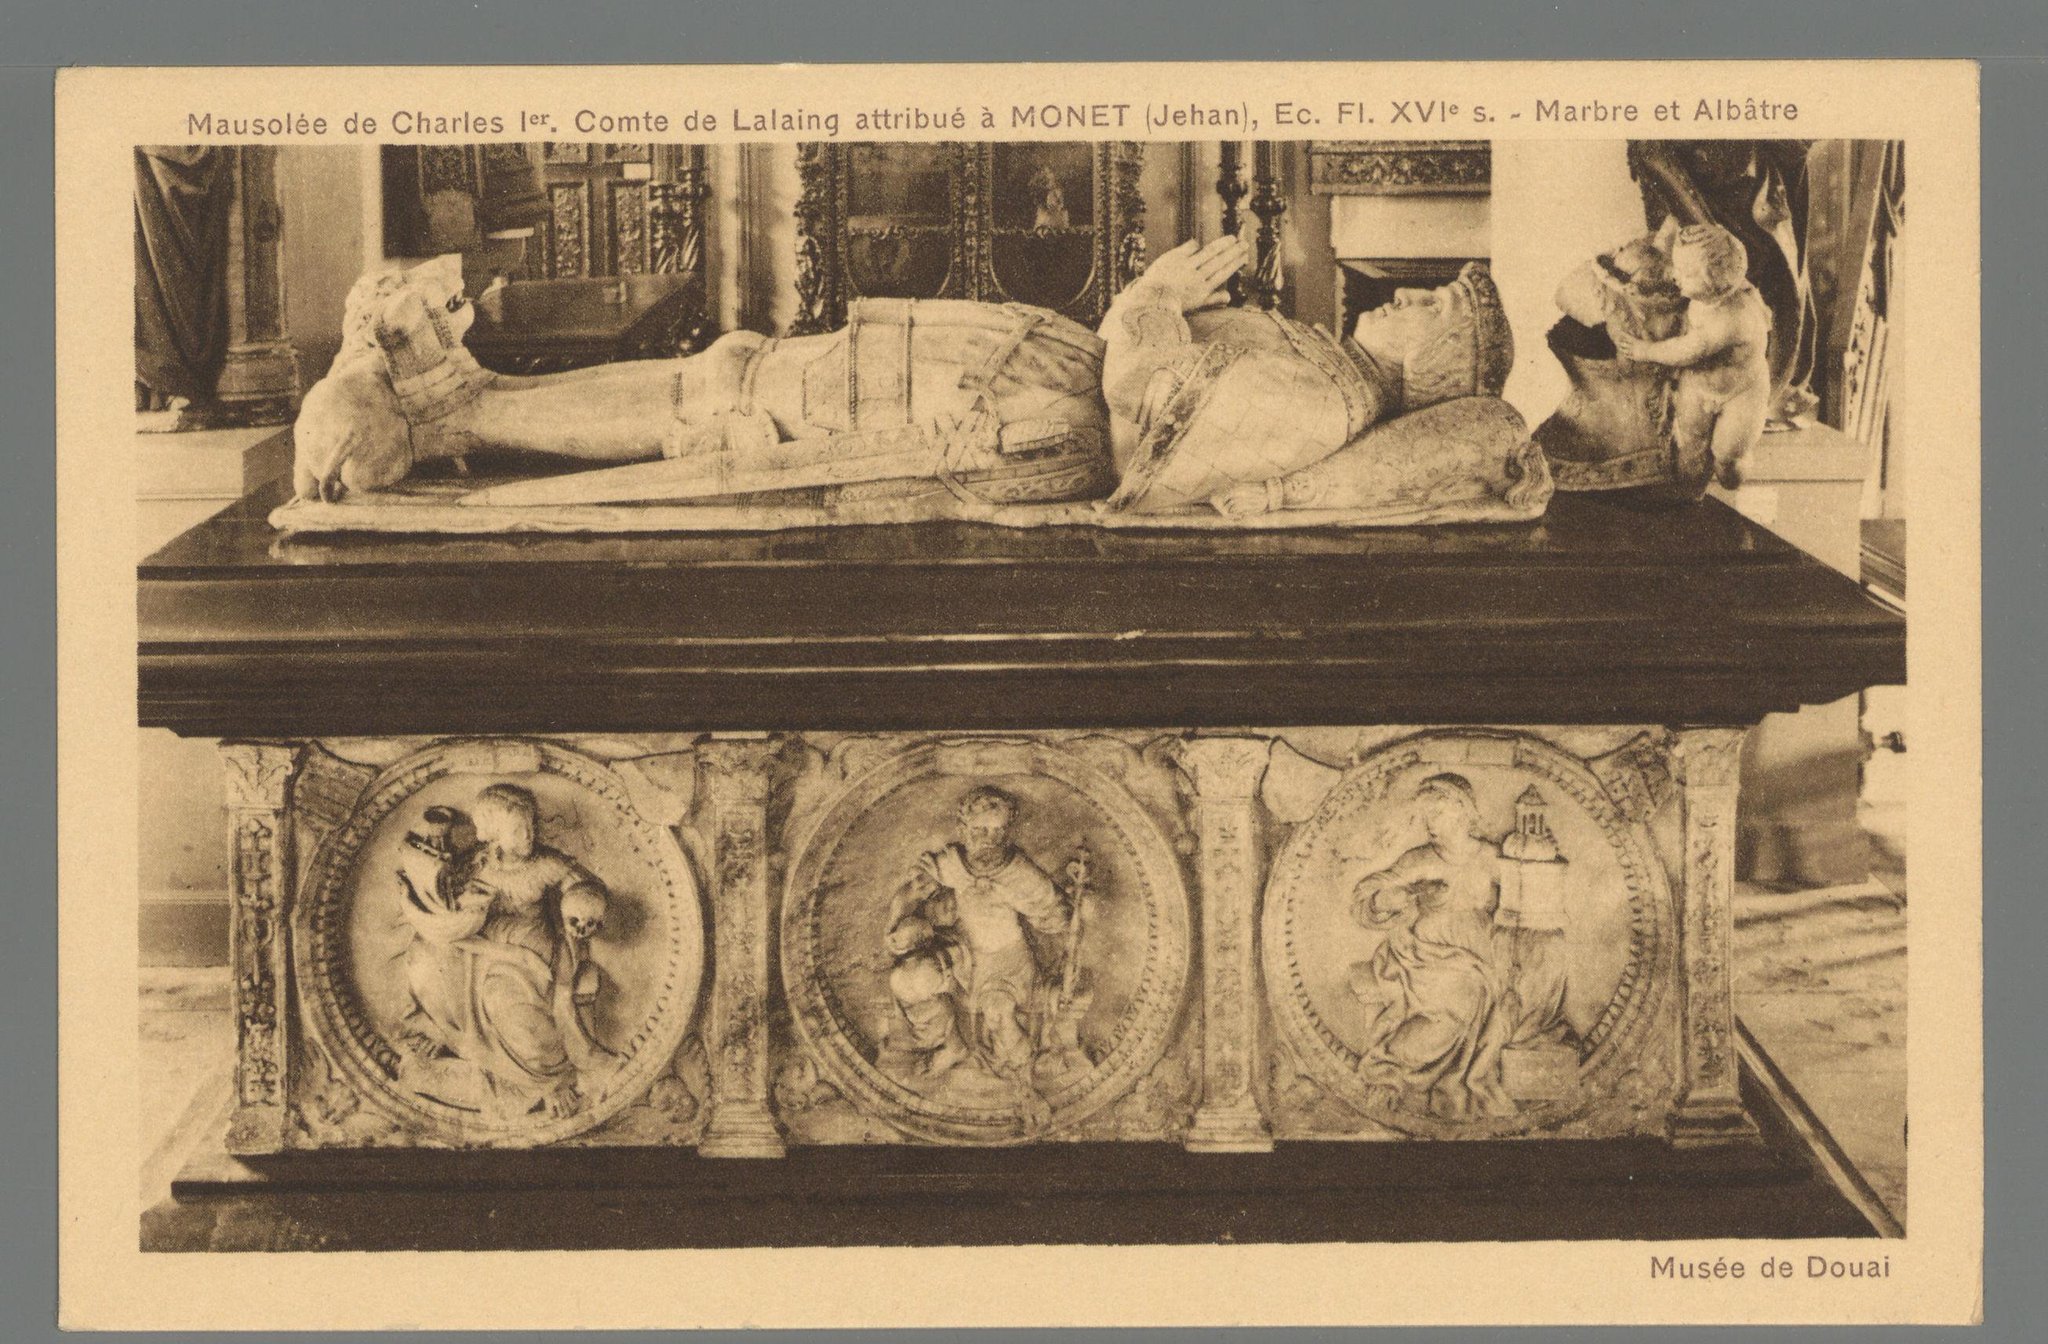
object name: ansichtkaart, prentbriefkaart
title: Mausolée de Charles Ier. Comte de Lalaing, attribué à Monet (Jehan), Ec. Fl. XVIe s. Marbre et Albâtre. Musée de Douai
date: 1903-1940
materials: cardboard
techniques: photograph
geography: douai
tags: earl, politician, mausoleum, sculpture